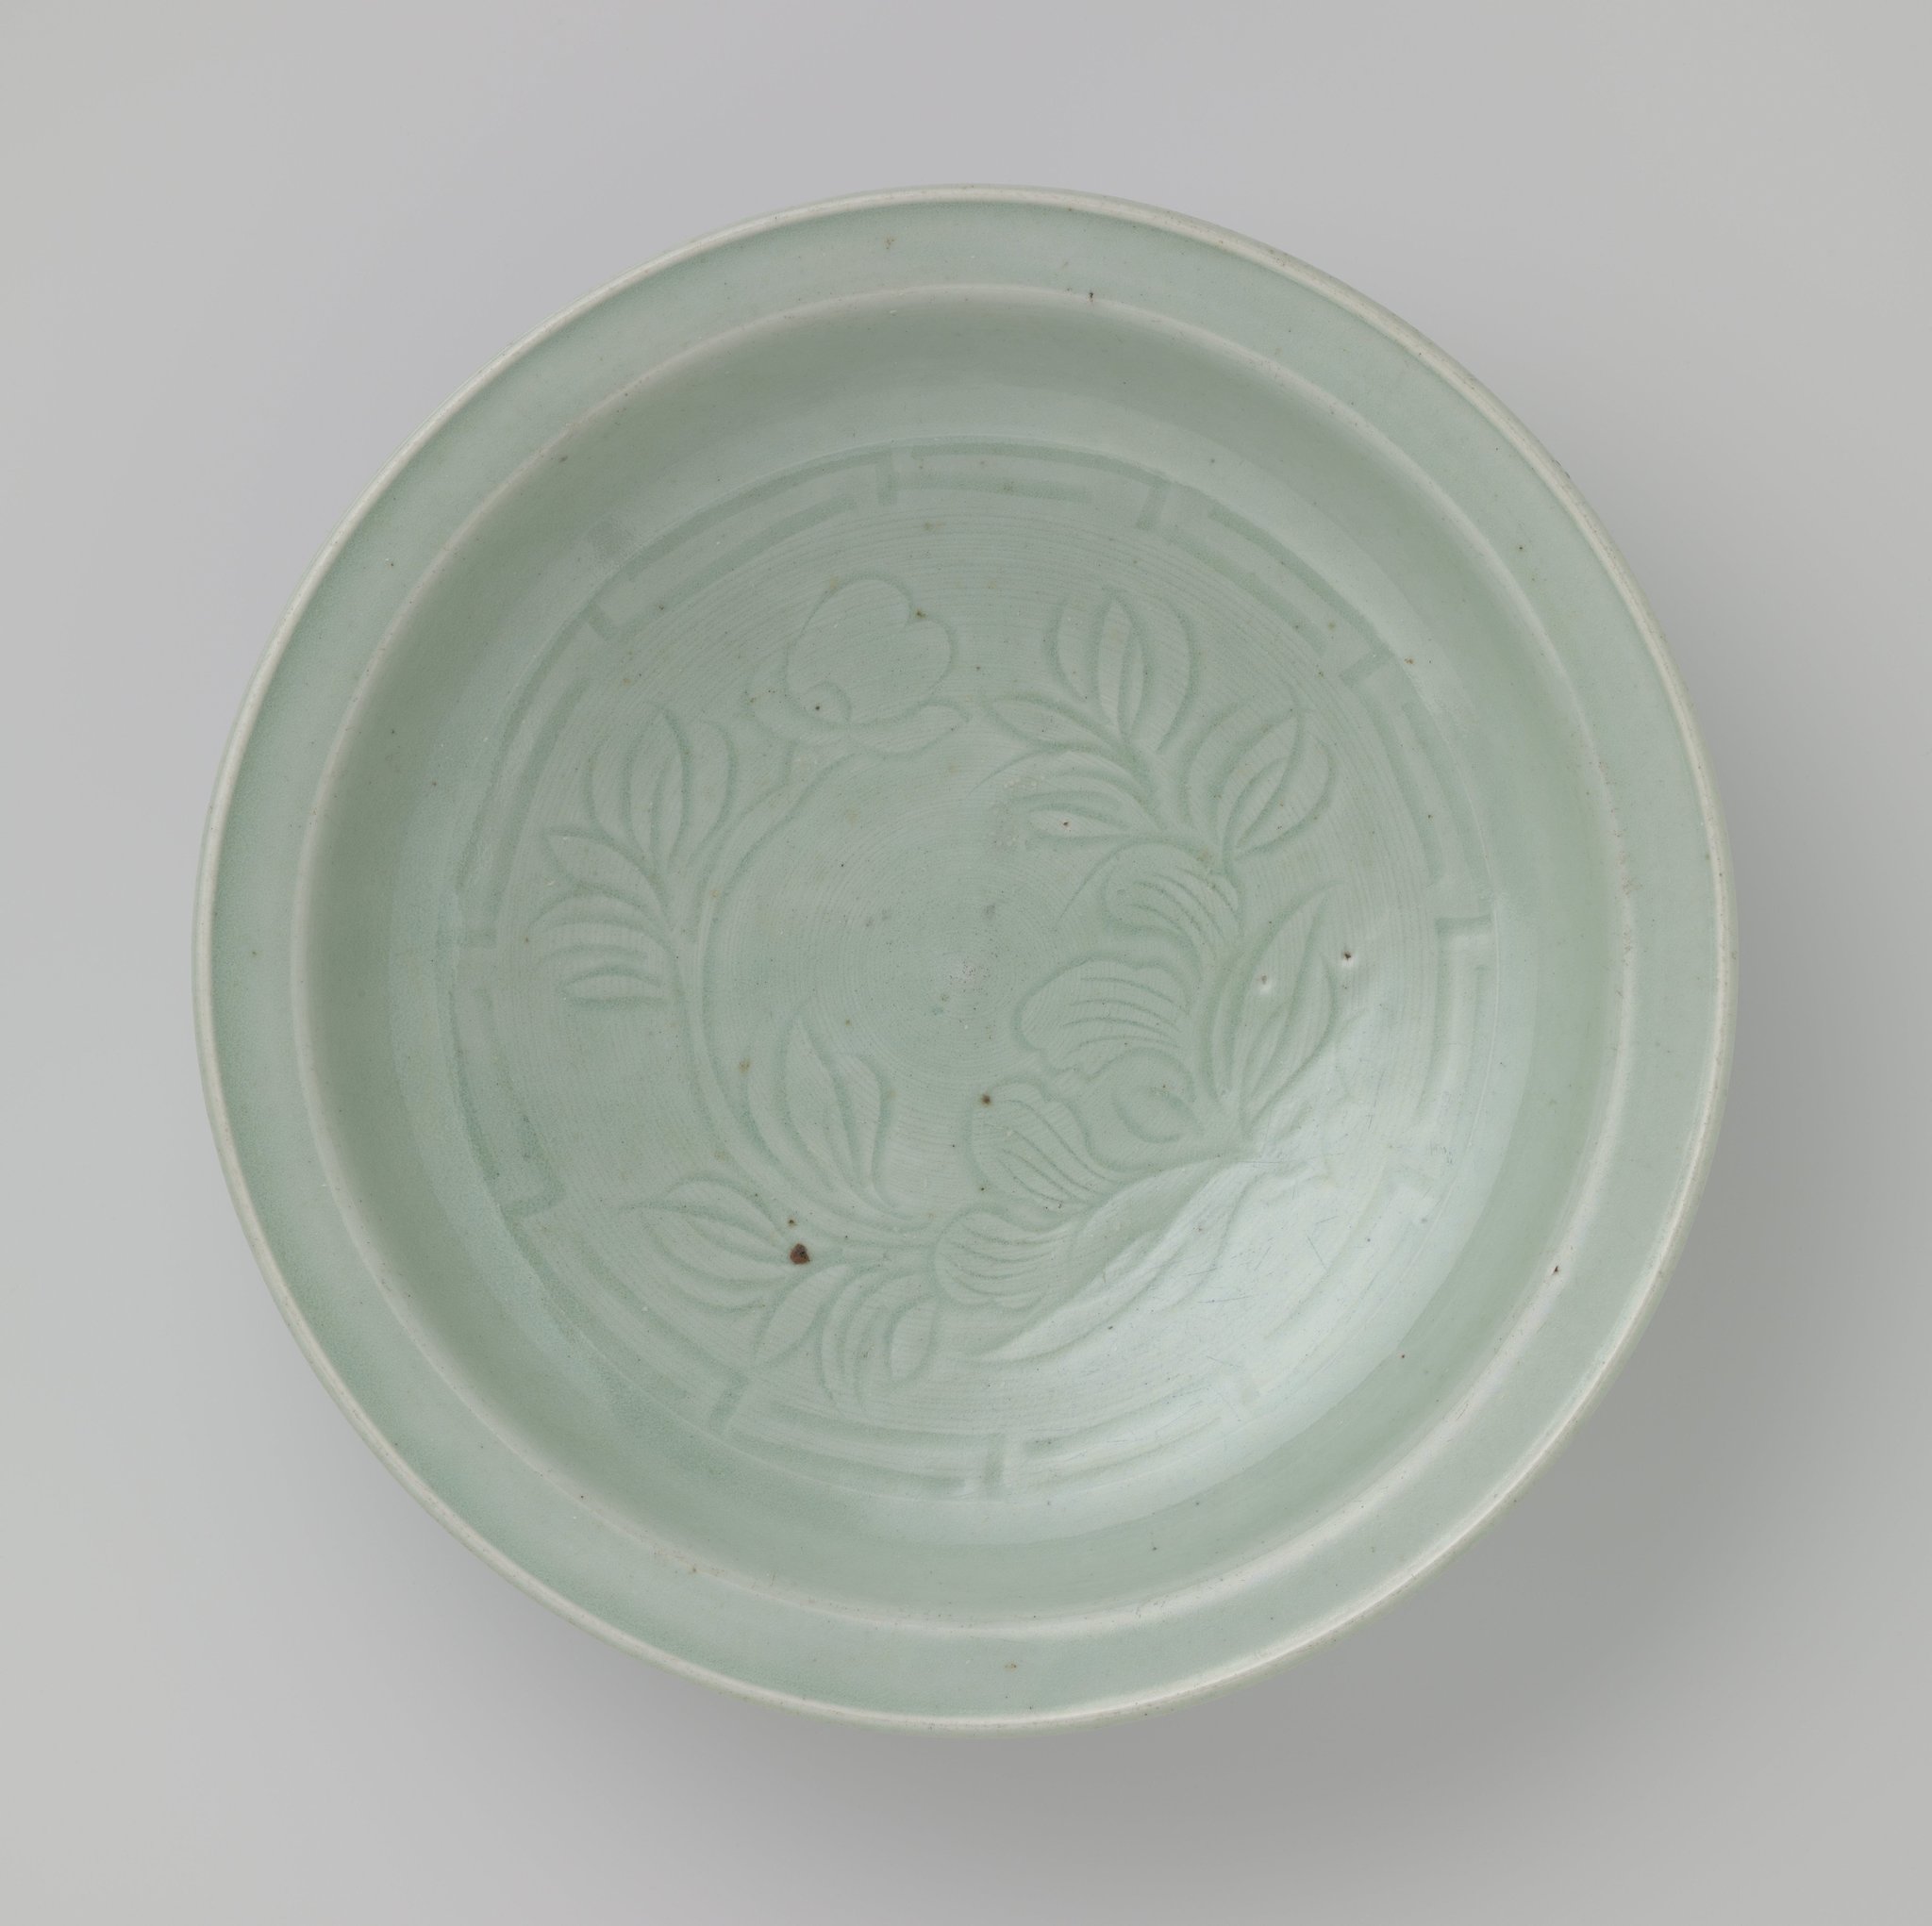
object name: platter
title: Dish with an incised flowering plant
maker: Anonymous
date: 1675-1699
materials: glaze, stoneware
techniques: engraving, firing, turning, vitrification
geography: japan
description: Schotel van steengoed met een smalle, platte rand, bedekt met een groen glazuur. Op het plat een ingegrifte bloeiende plant binnen een geometrische band. Binnen de voetring een ongeglazuurde band van de roodbakkende klei. In het centrum van de voetring een verzonken cirkel, die wel geglazuurd is. Celadon.